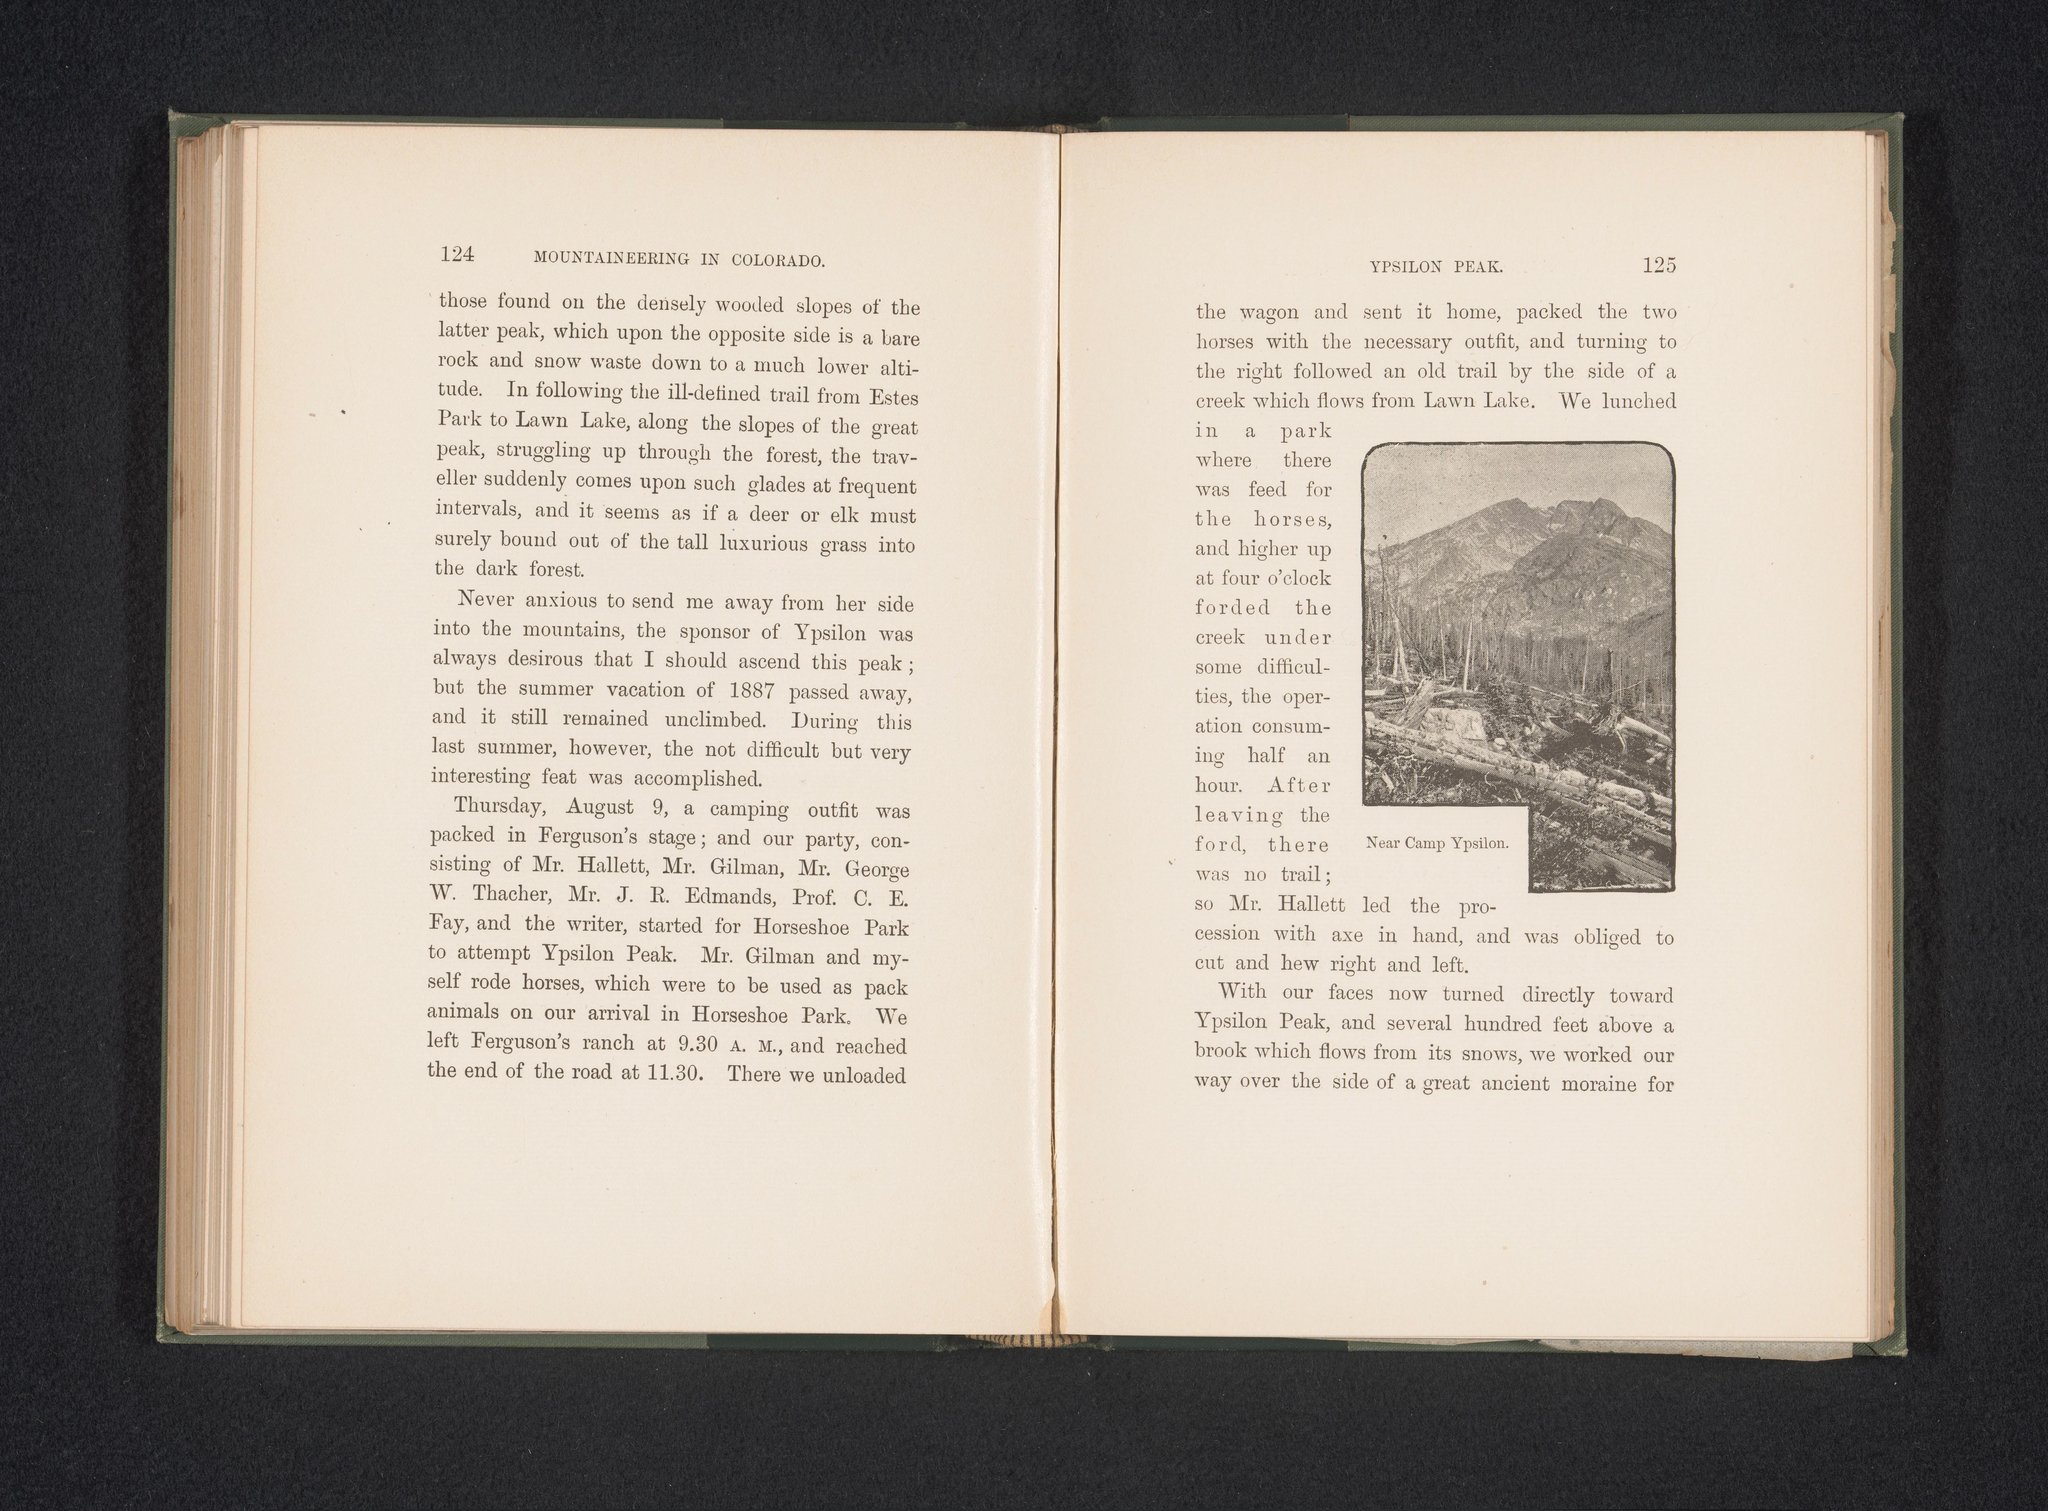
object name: page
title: Near Camp Ypsilon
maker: frederick hastings chapin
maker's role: antropoloog, archeoloog, fotograaf, schrijver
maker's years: 1852-1900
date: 1885-1890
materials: paper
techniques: autotype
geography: boston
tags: landscapes, mountains